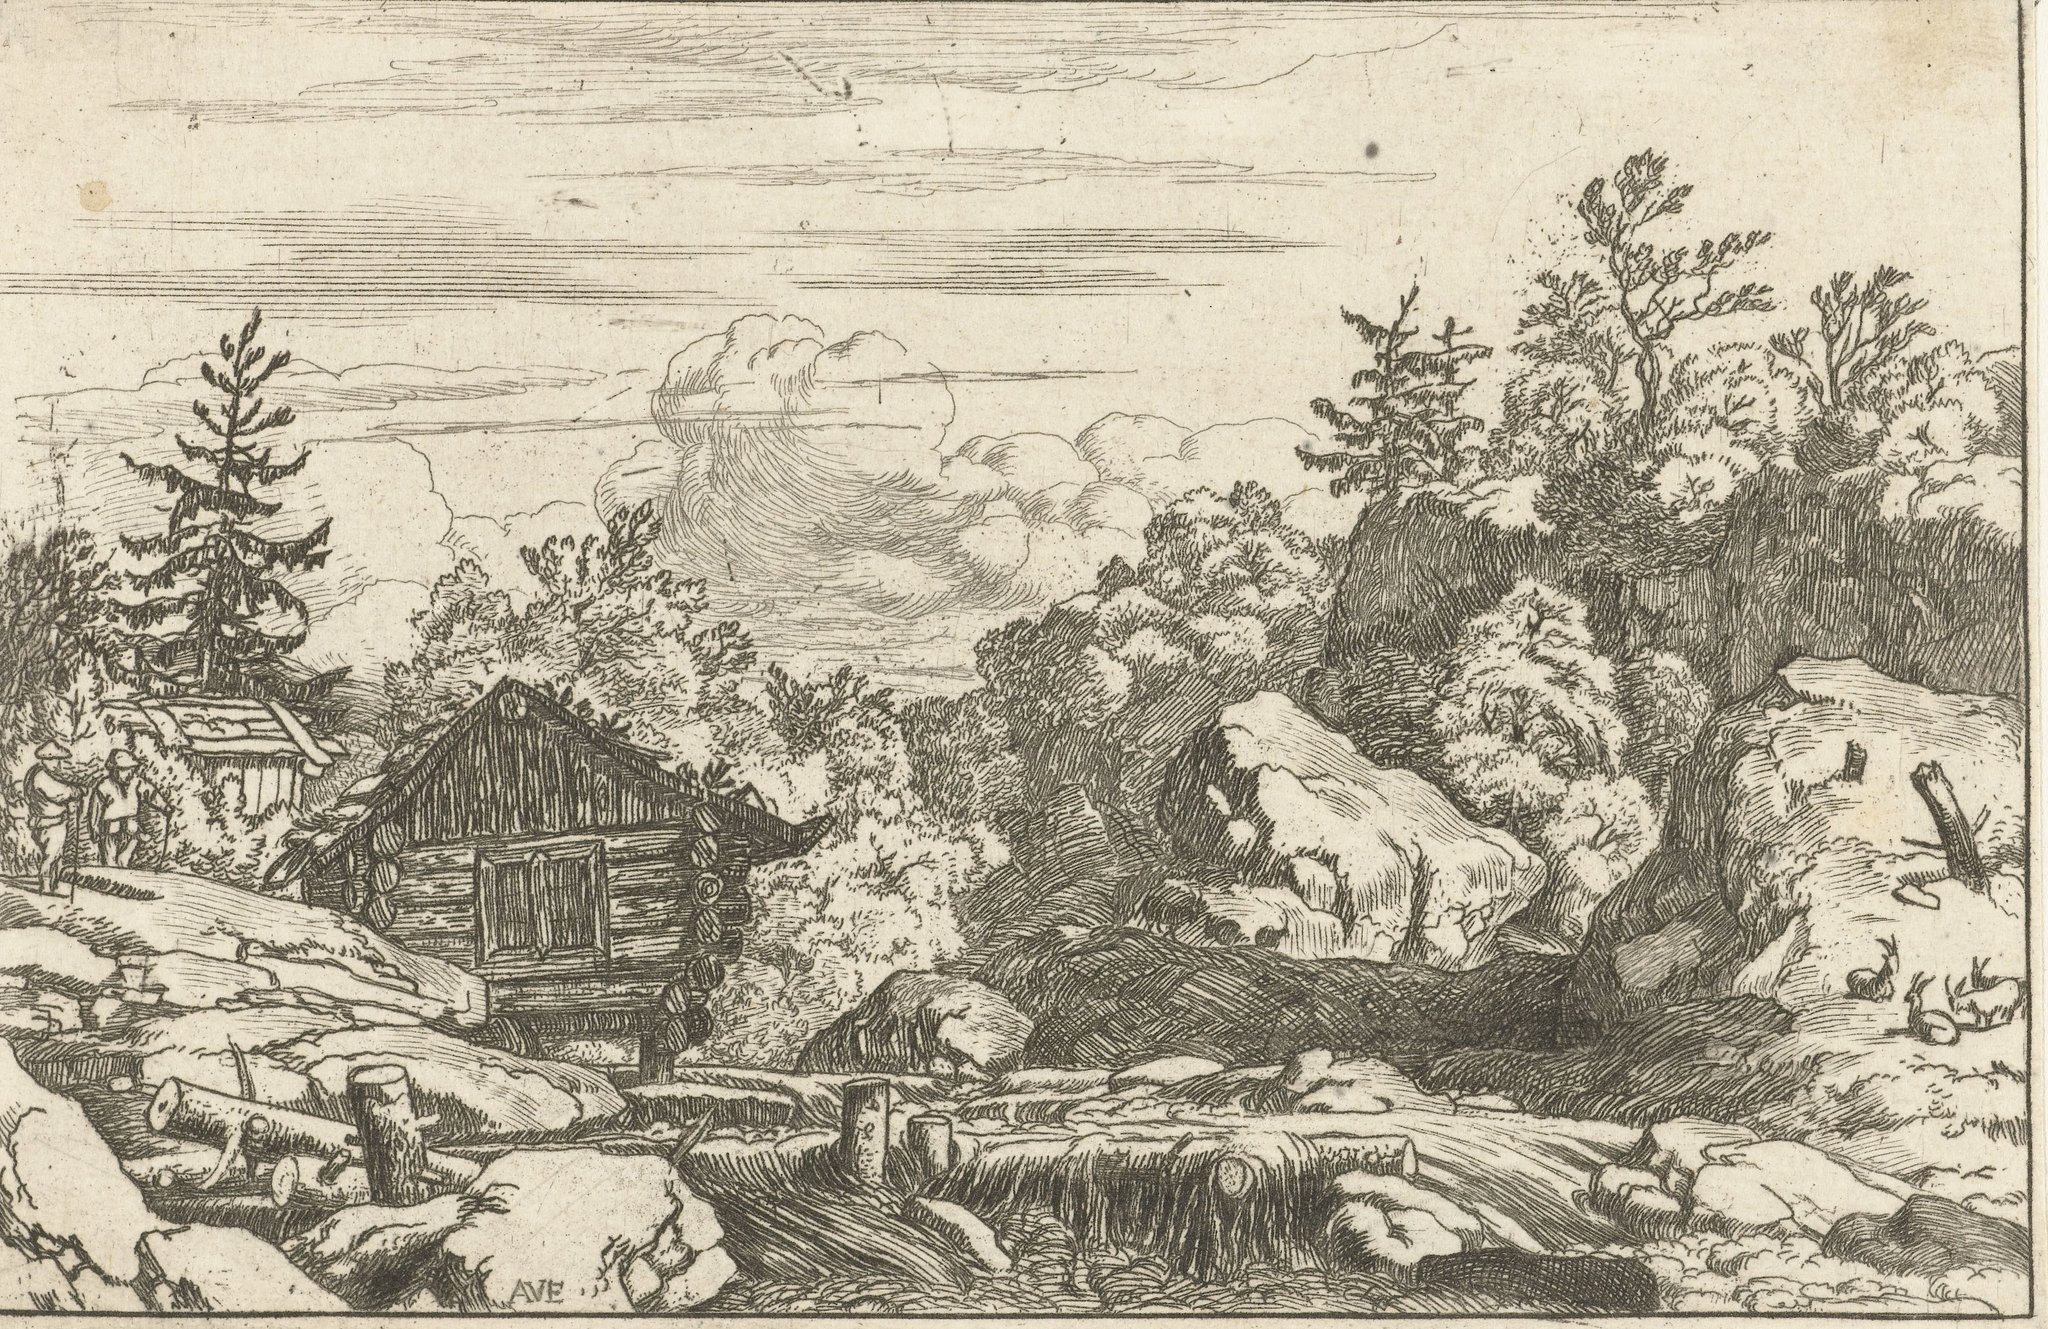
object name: print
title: Landschap met hut bij waterval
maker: allaert van everdingen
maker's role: draughtsman, painter, print maker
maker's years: 1621-1675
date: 1631-1675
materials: paper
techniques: etching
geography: netherlands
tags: waterfall (+ landscape with figures, staffage)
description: Rotsachtig landschap met bomen, struikgewas en een kleine waterval. Op de rots naast de houten hut staan twee personen.